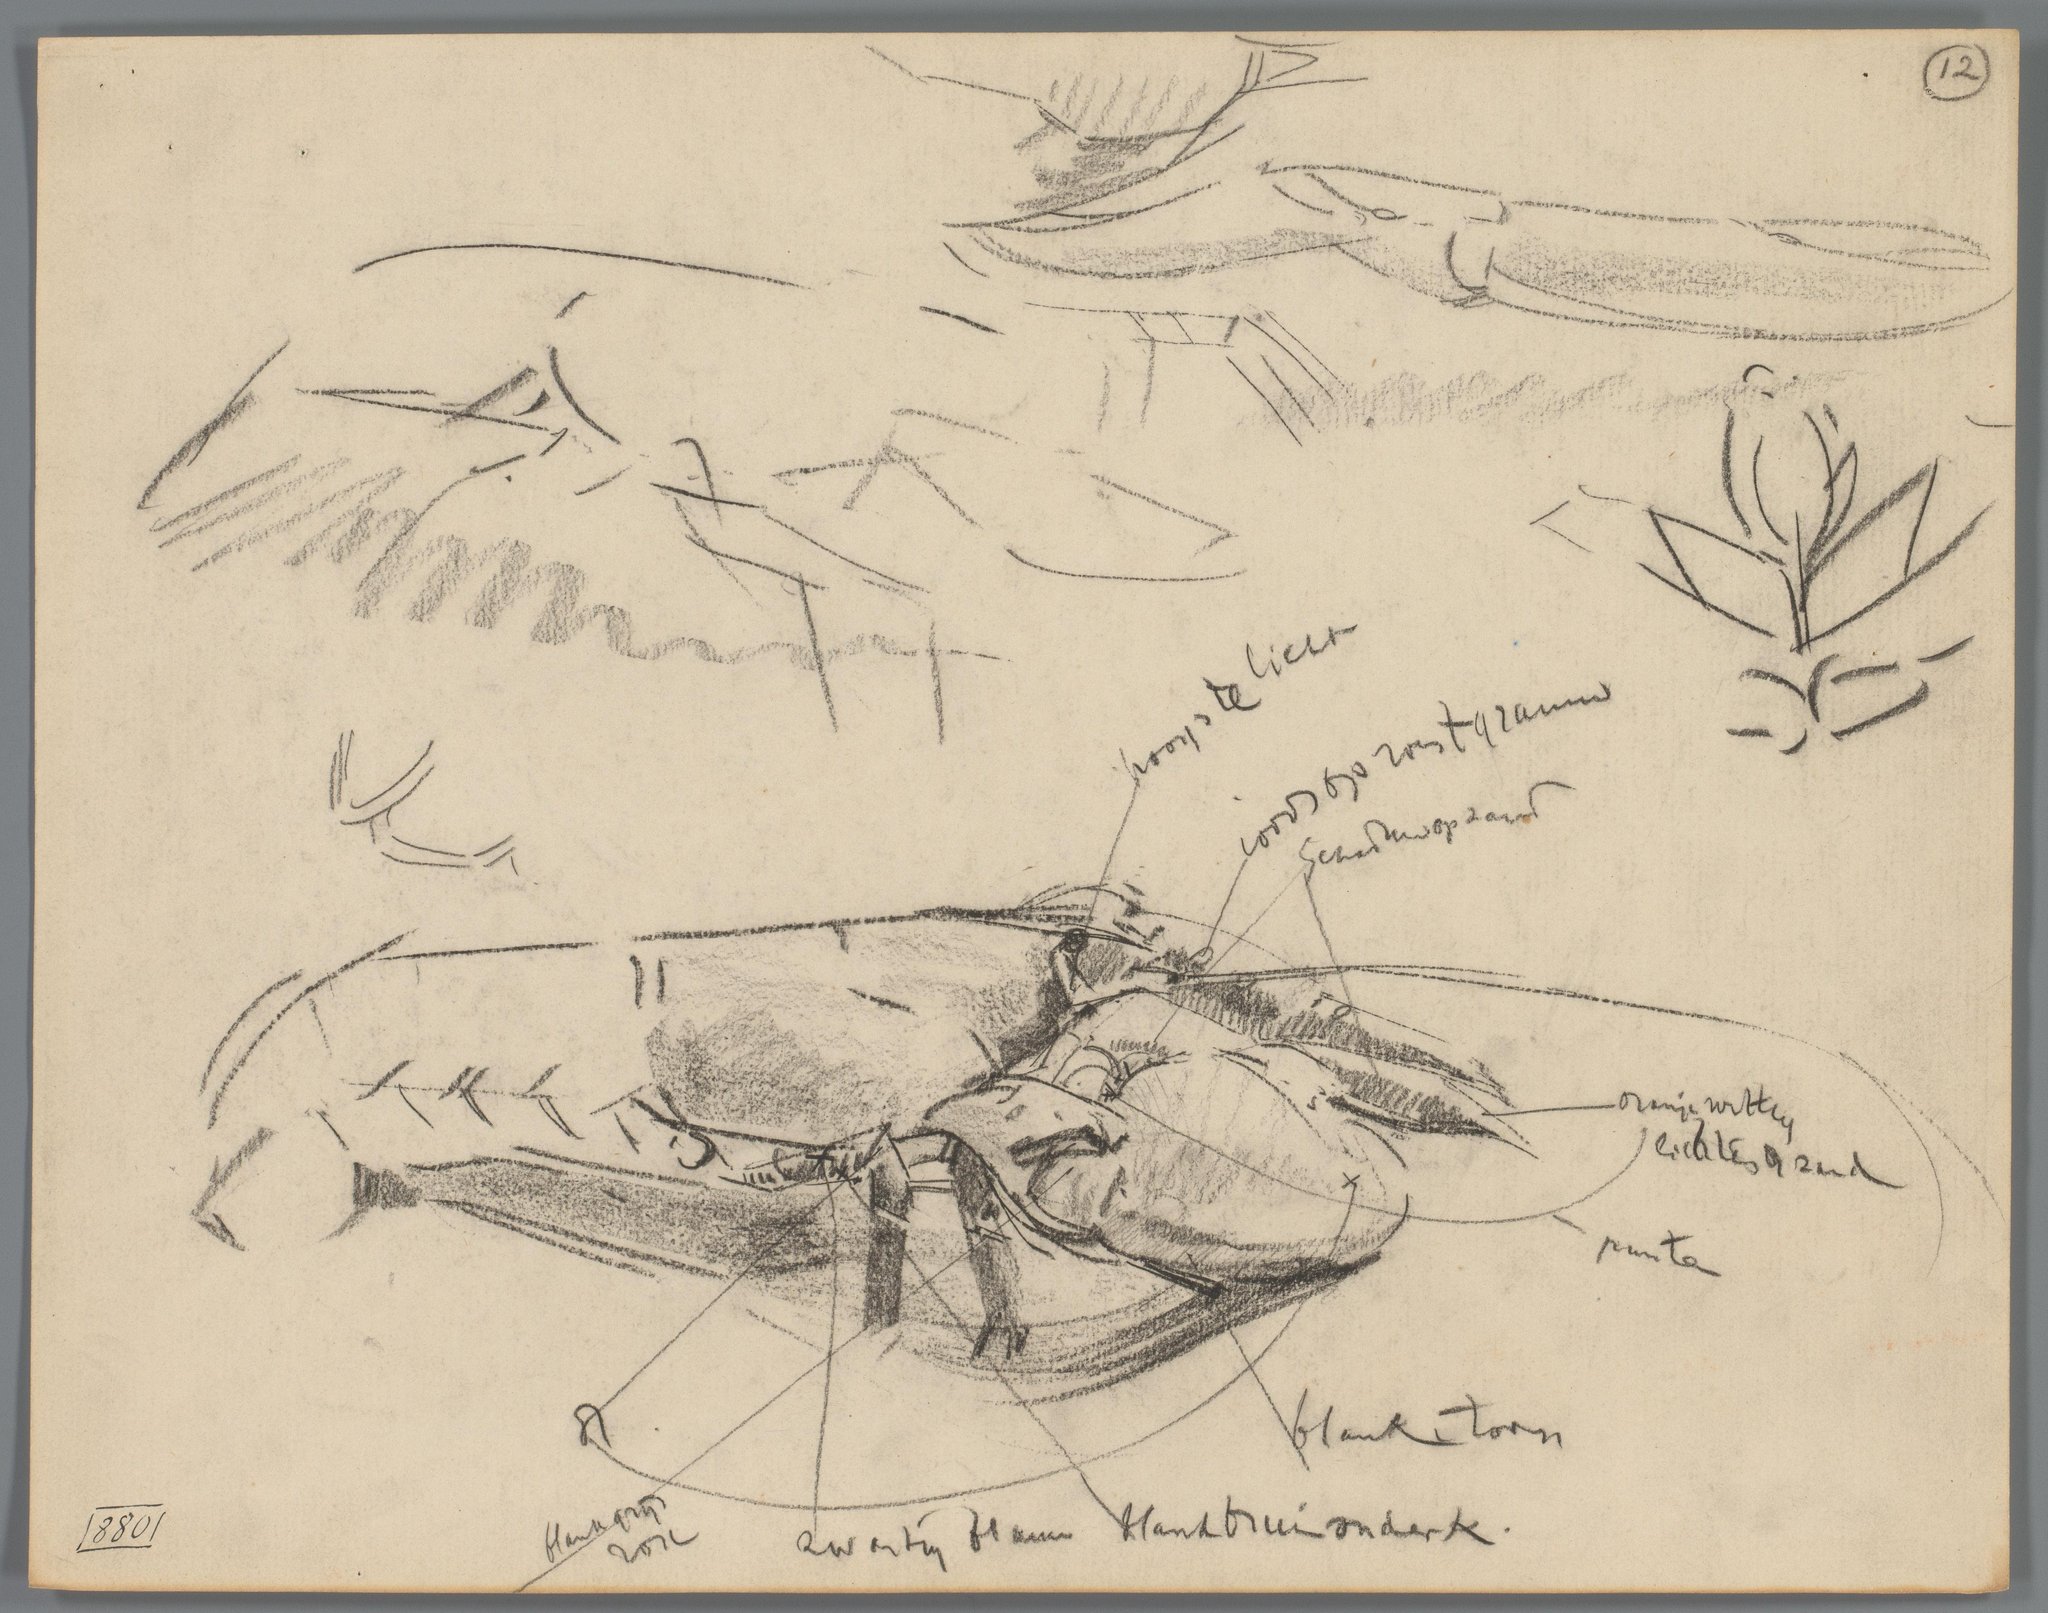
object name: drawing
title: Studies van het kopborststuk en de scharen van kreeften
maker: gerrit willem dijsselhof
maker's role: designer, draughtsman, print maker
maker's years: 1866-1924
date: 1876-1924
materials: chalk, paper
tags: crustaceans: lobster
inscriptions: watermark, number: ‘880’, number: ‘12’